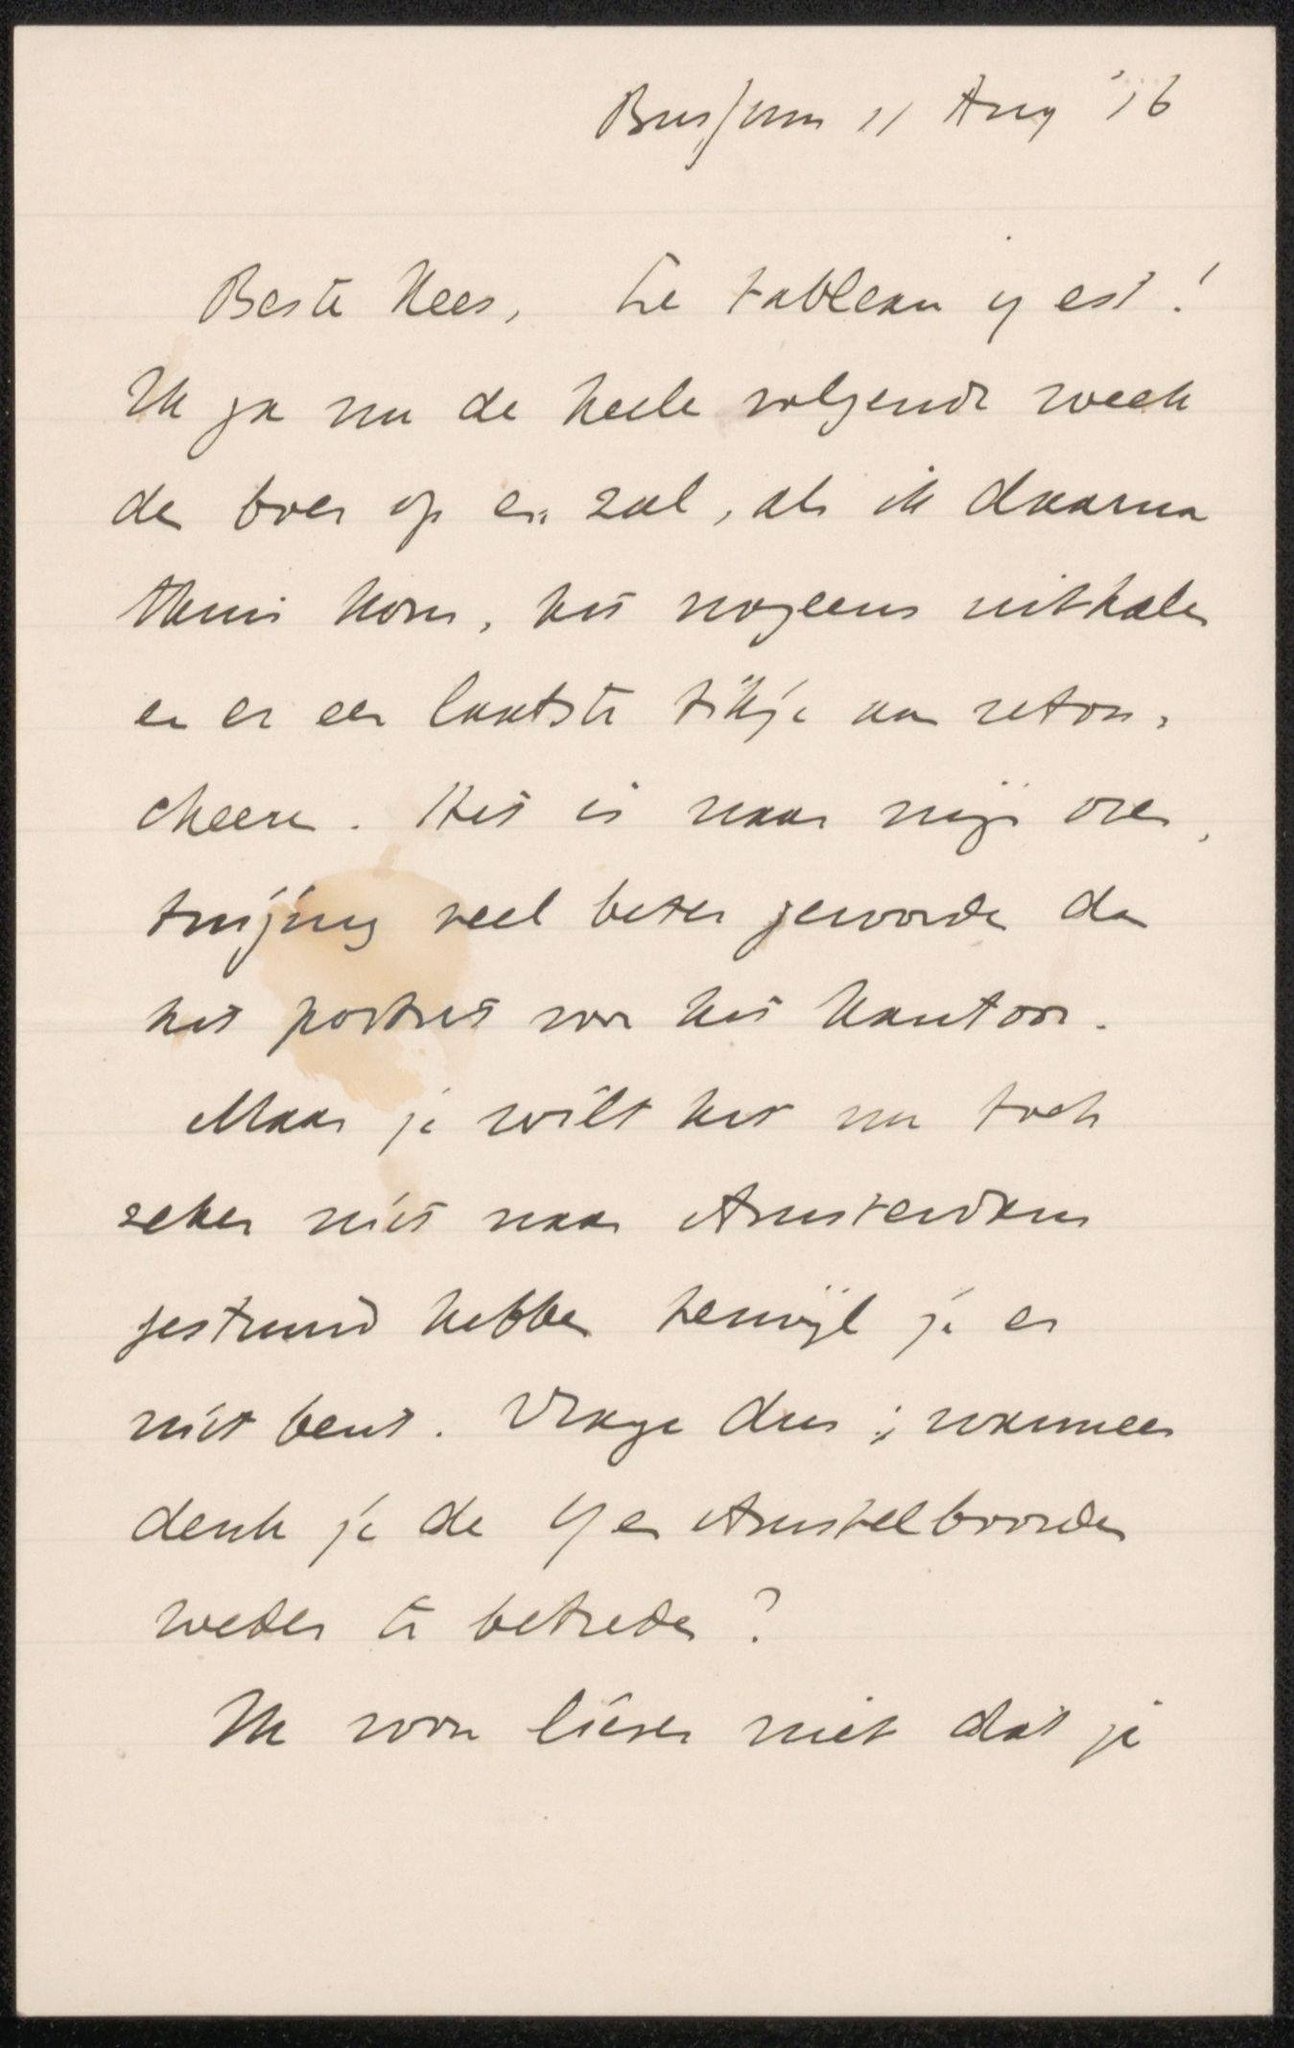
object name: letter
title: Brief aan Cornelis Gerardus 't Hooft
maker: jan veth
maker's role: designer, draughtsman, painter, print maker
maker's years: 1864-1925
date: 1916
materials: ink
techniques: pen, writing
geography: bussum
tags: leiden, rembrandt van rijn, cornelis gerardus 't hooft, the graphic arts, anonymous historical person portrayed, painting (including book-illumination, miniature-painting), money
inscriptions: collector's mark: ‘RPK’